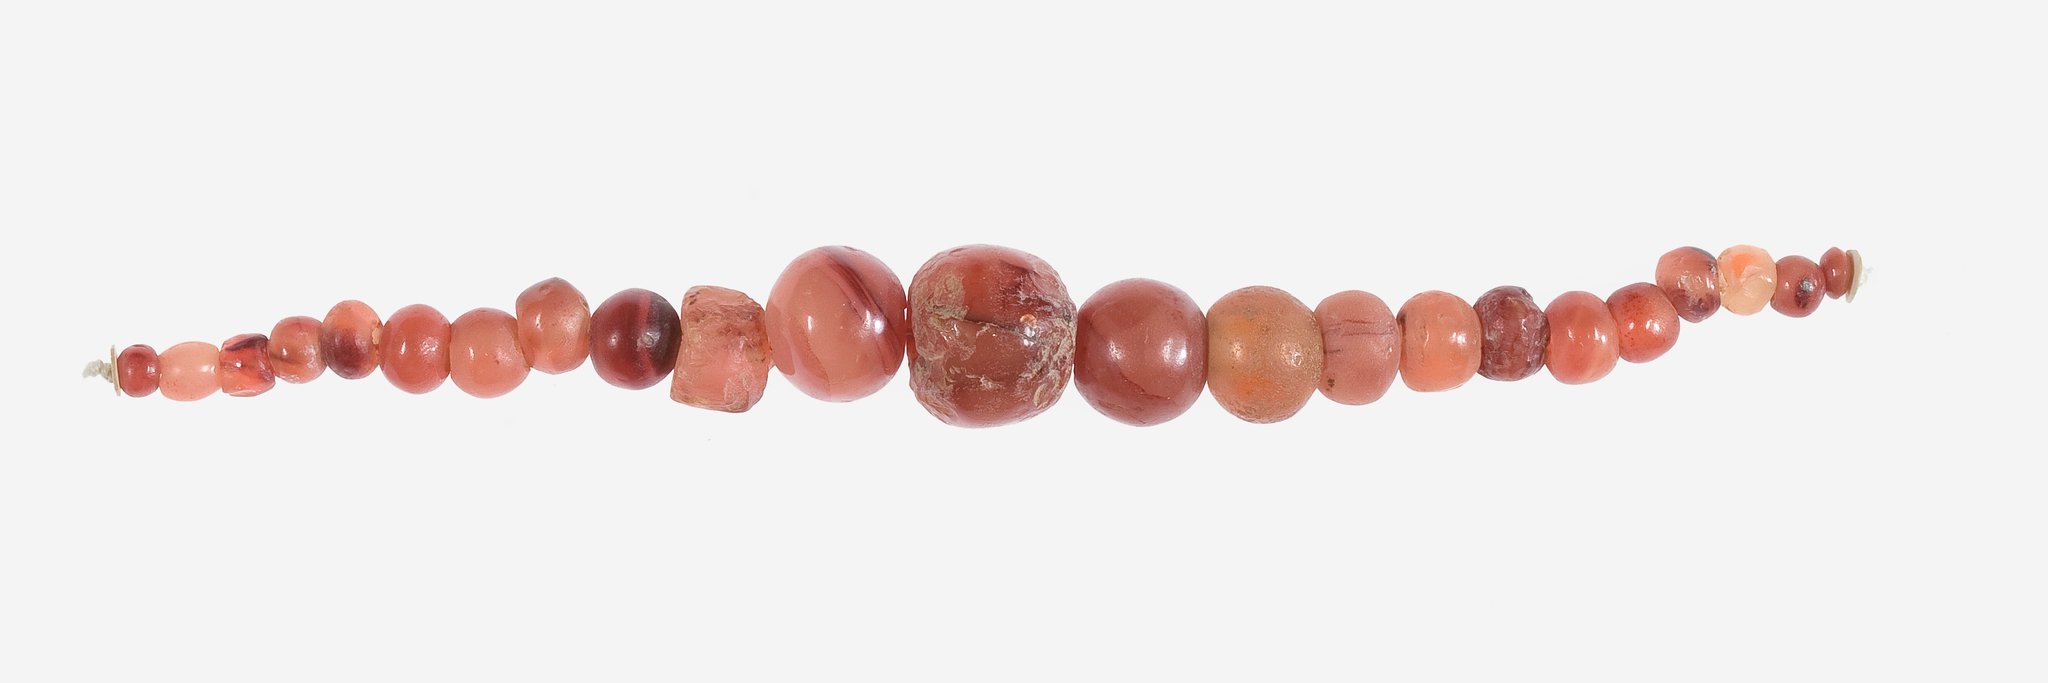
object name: bead, string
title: String of Ball Beads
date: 1390-1352 BCE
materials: gemstone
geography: egypt